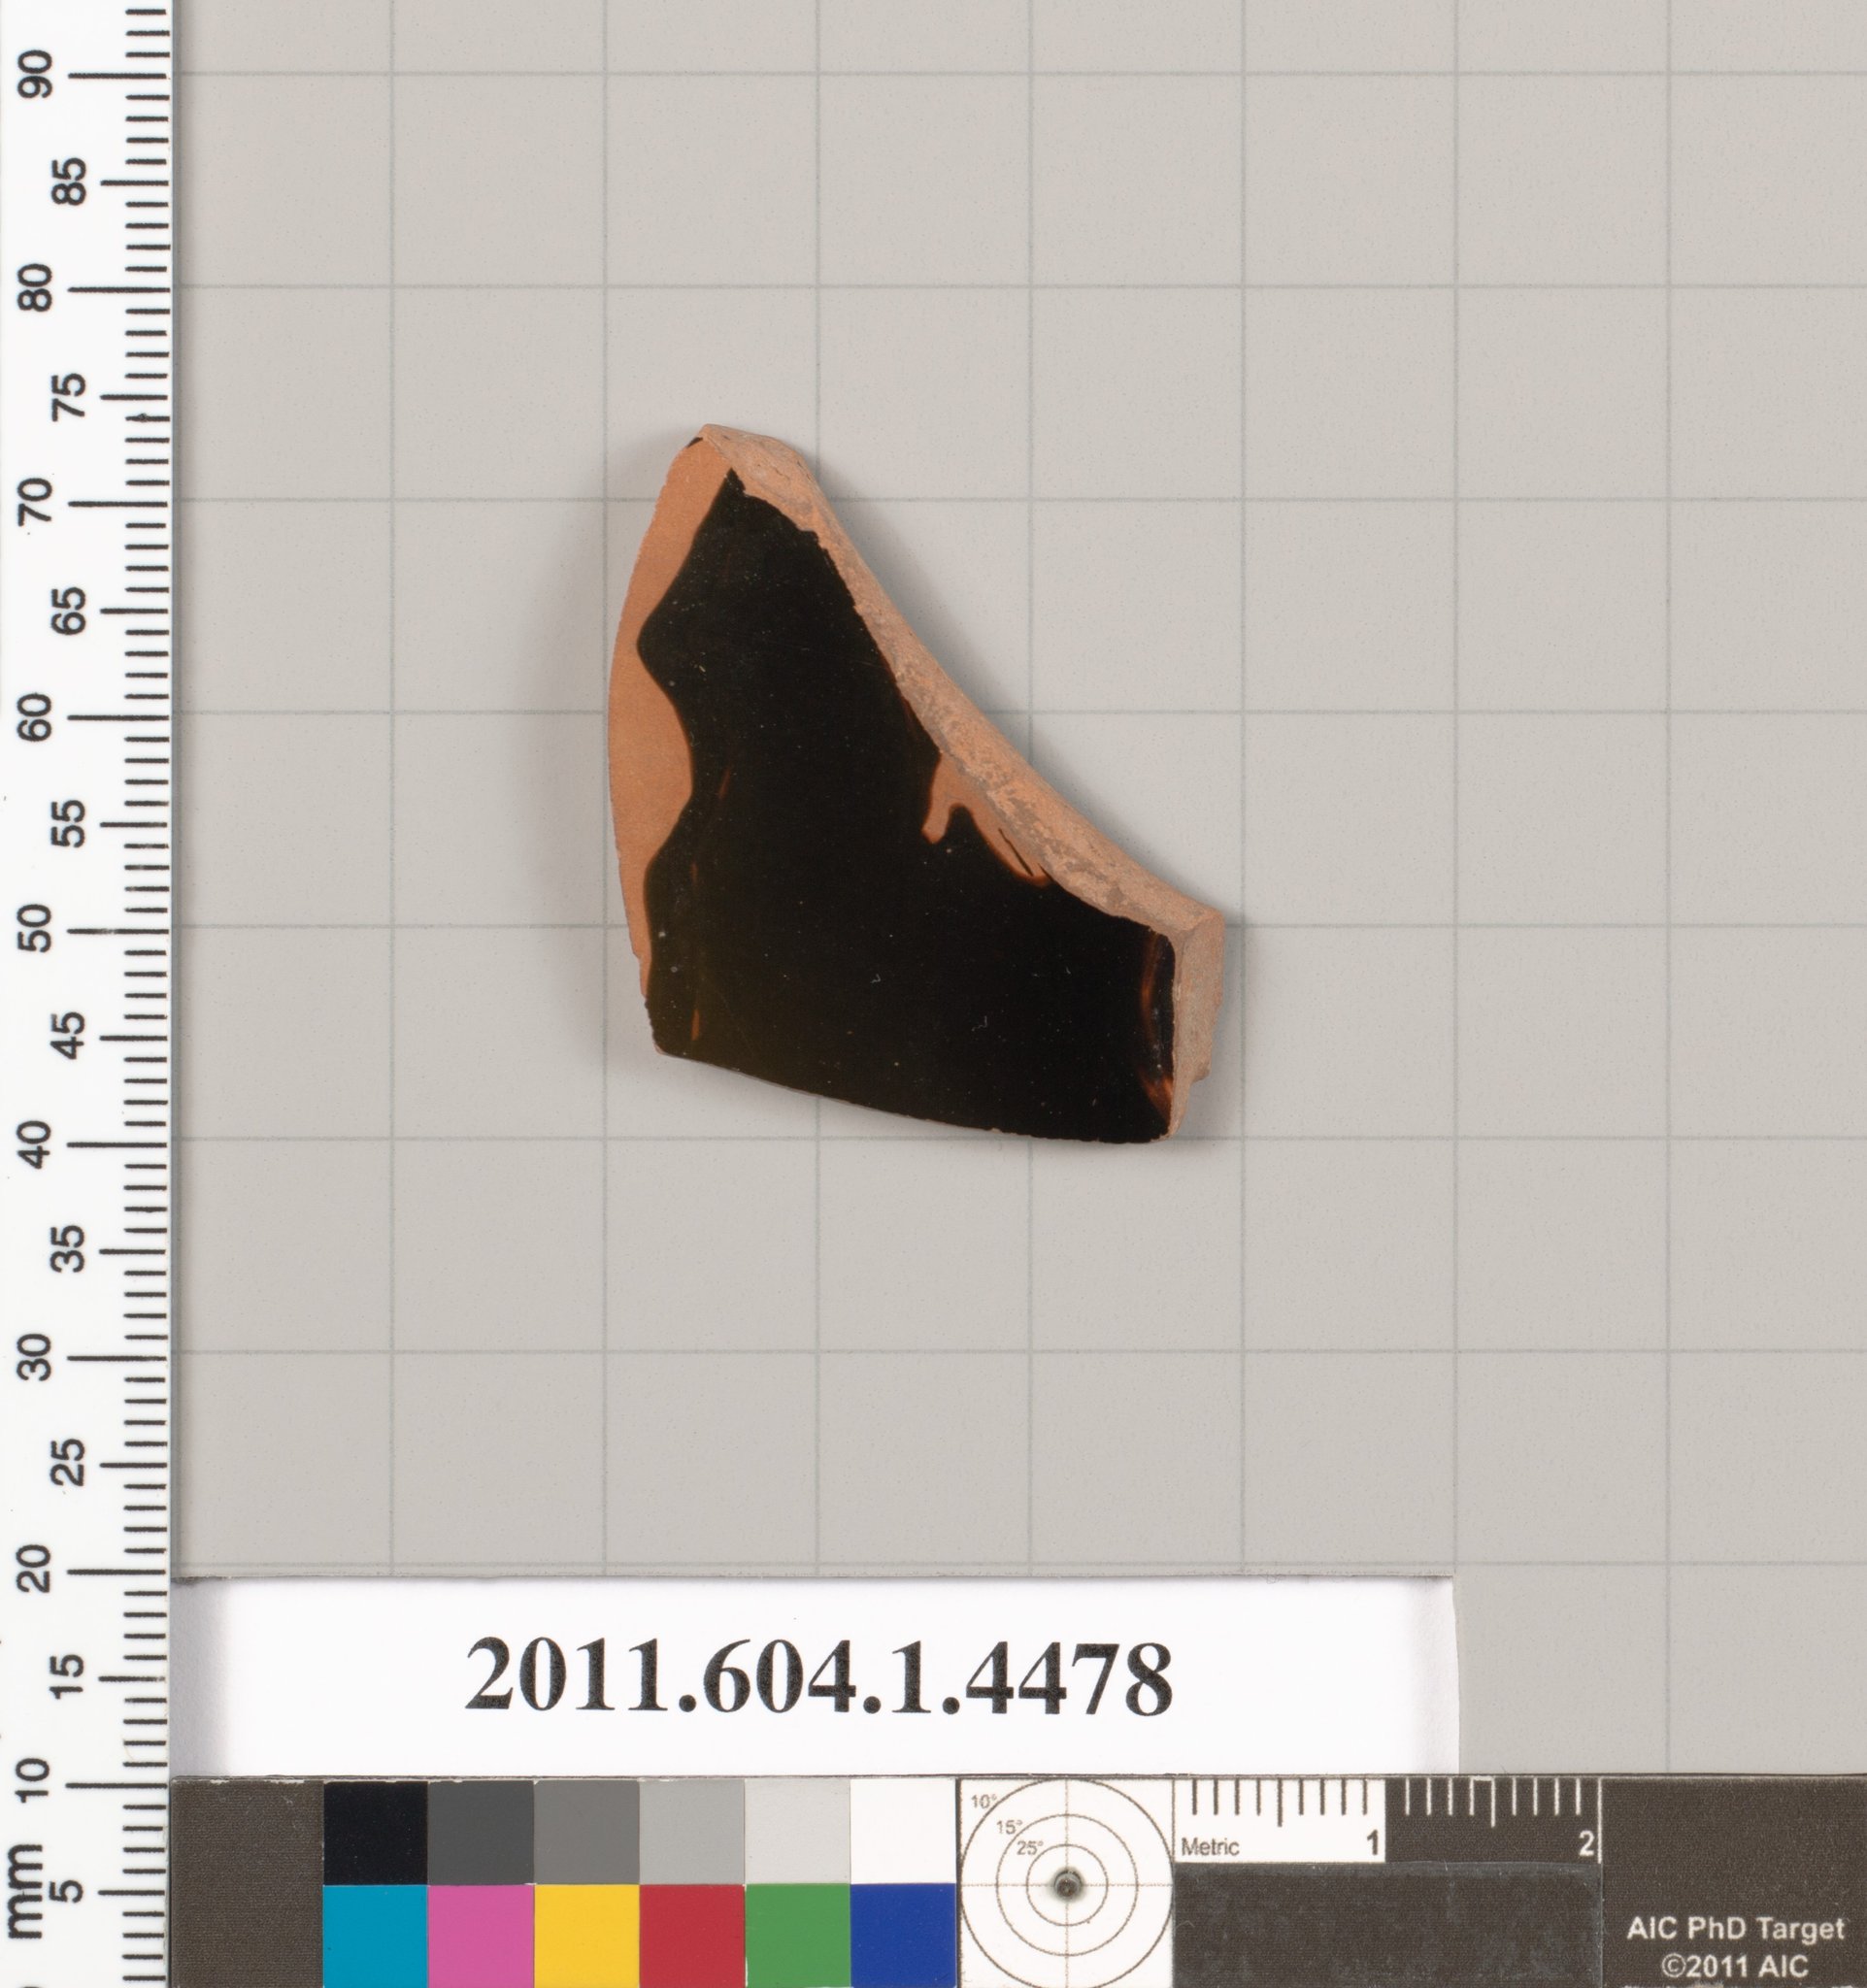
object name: kylix fragment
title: Terracotta fragment of a kylix (drinking cup)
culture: greek, attic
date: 475-451 BCE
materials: terracotta